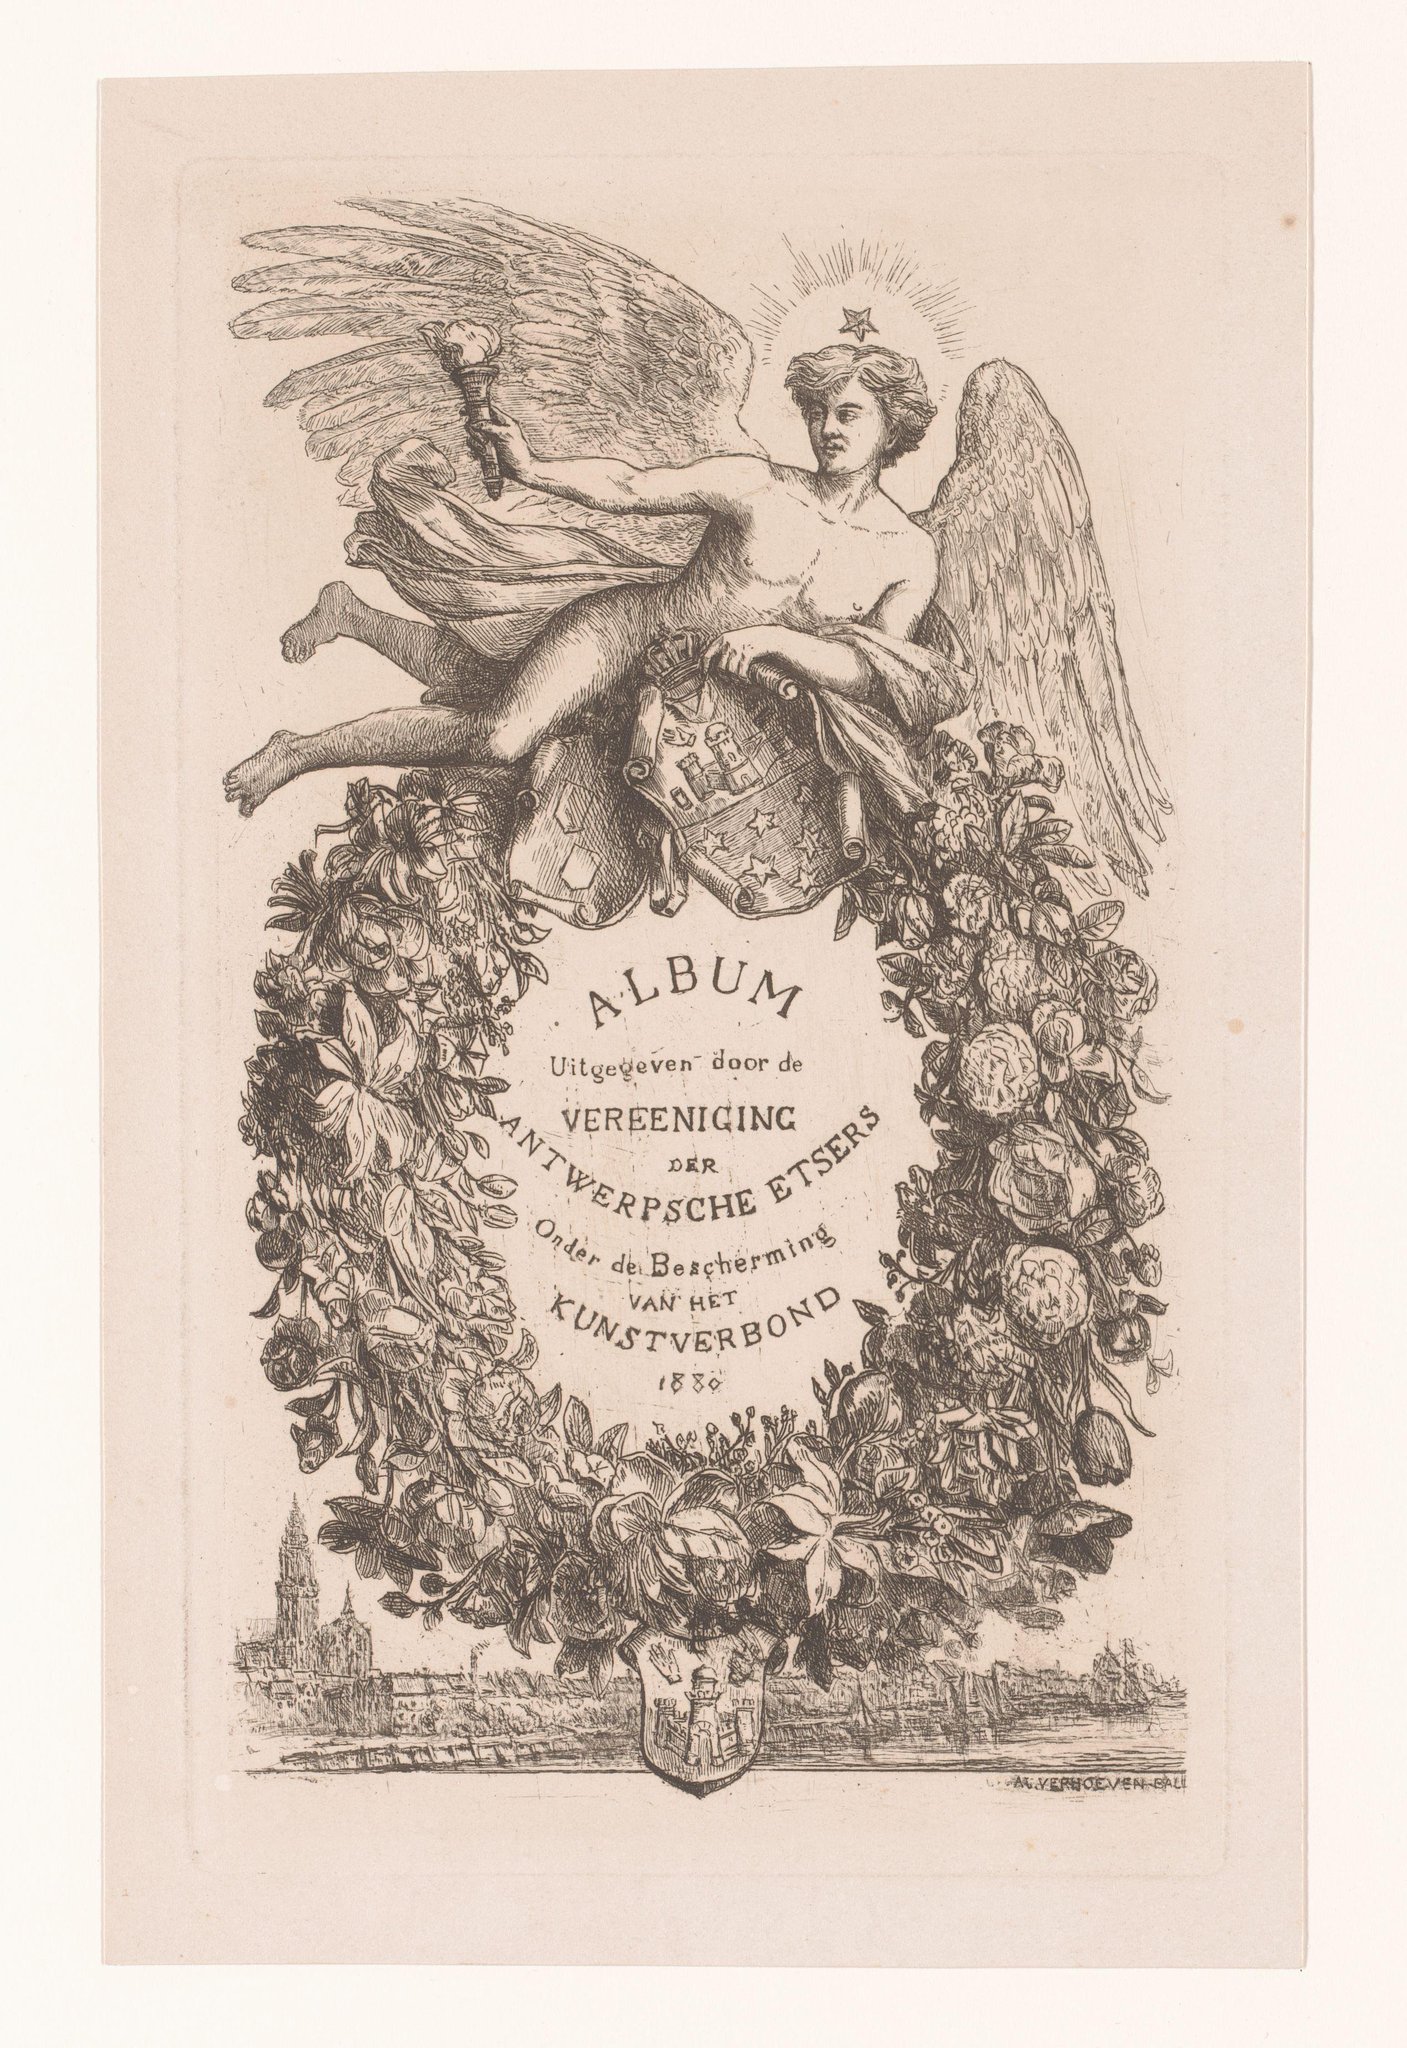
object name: titelprent, frontispice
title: Titelprent met allegorie op Antwerpen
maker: adrien joseph verhoeven-ball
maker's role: draughtsman, print maker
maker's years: 1824-1882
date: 1880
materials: paper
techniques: drypoint, etching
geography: antwerp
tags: cities represented allegorically or symbolically, antwerp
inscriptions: collector's mark: Lugt 2228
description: Titelprent voor een album, uitgegeven door de Vereeniging der Antwerpsche Etsers in 1880.